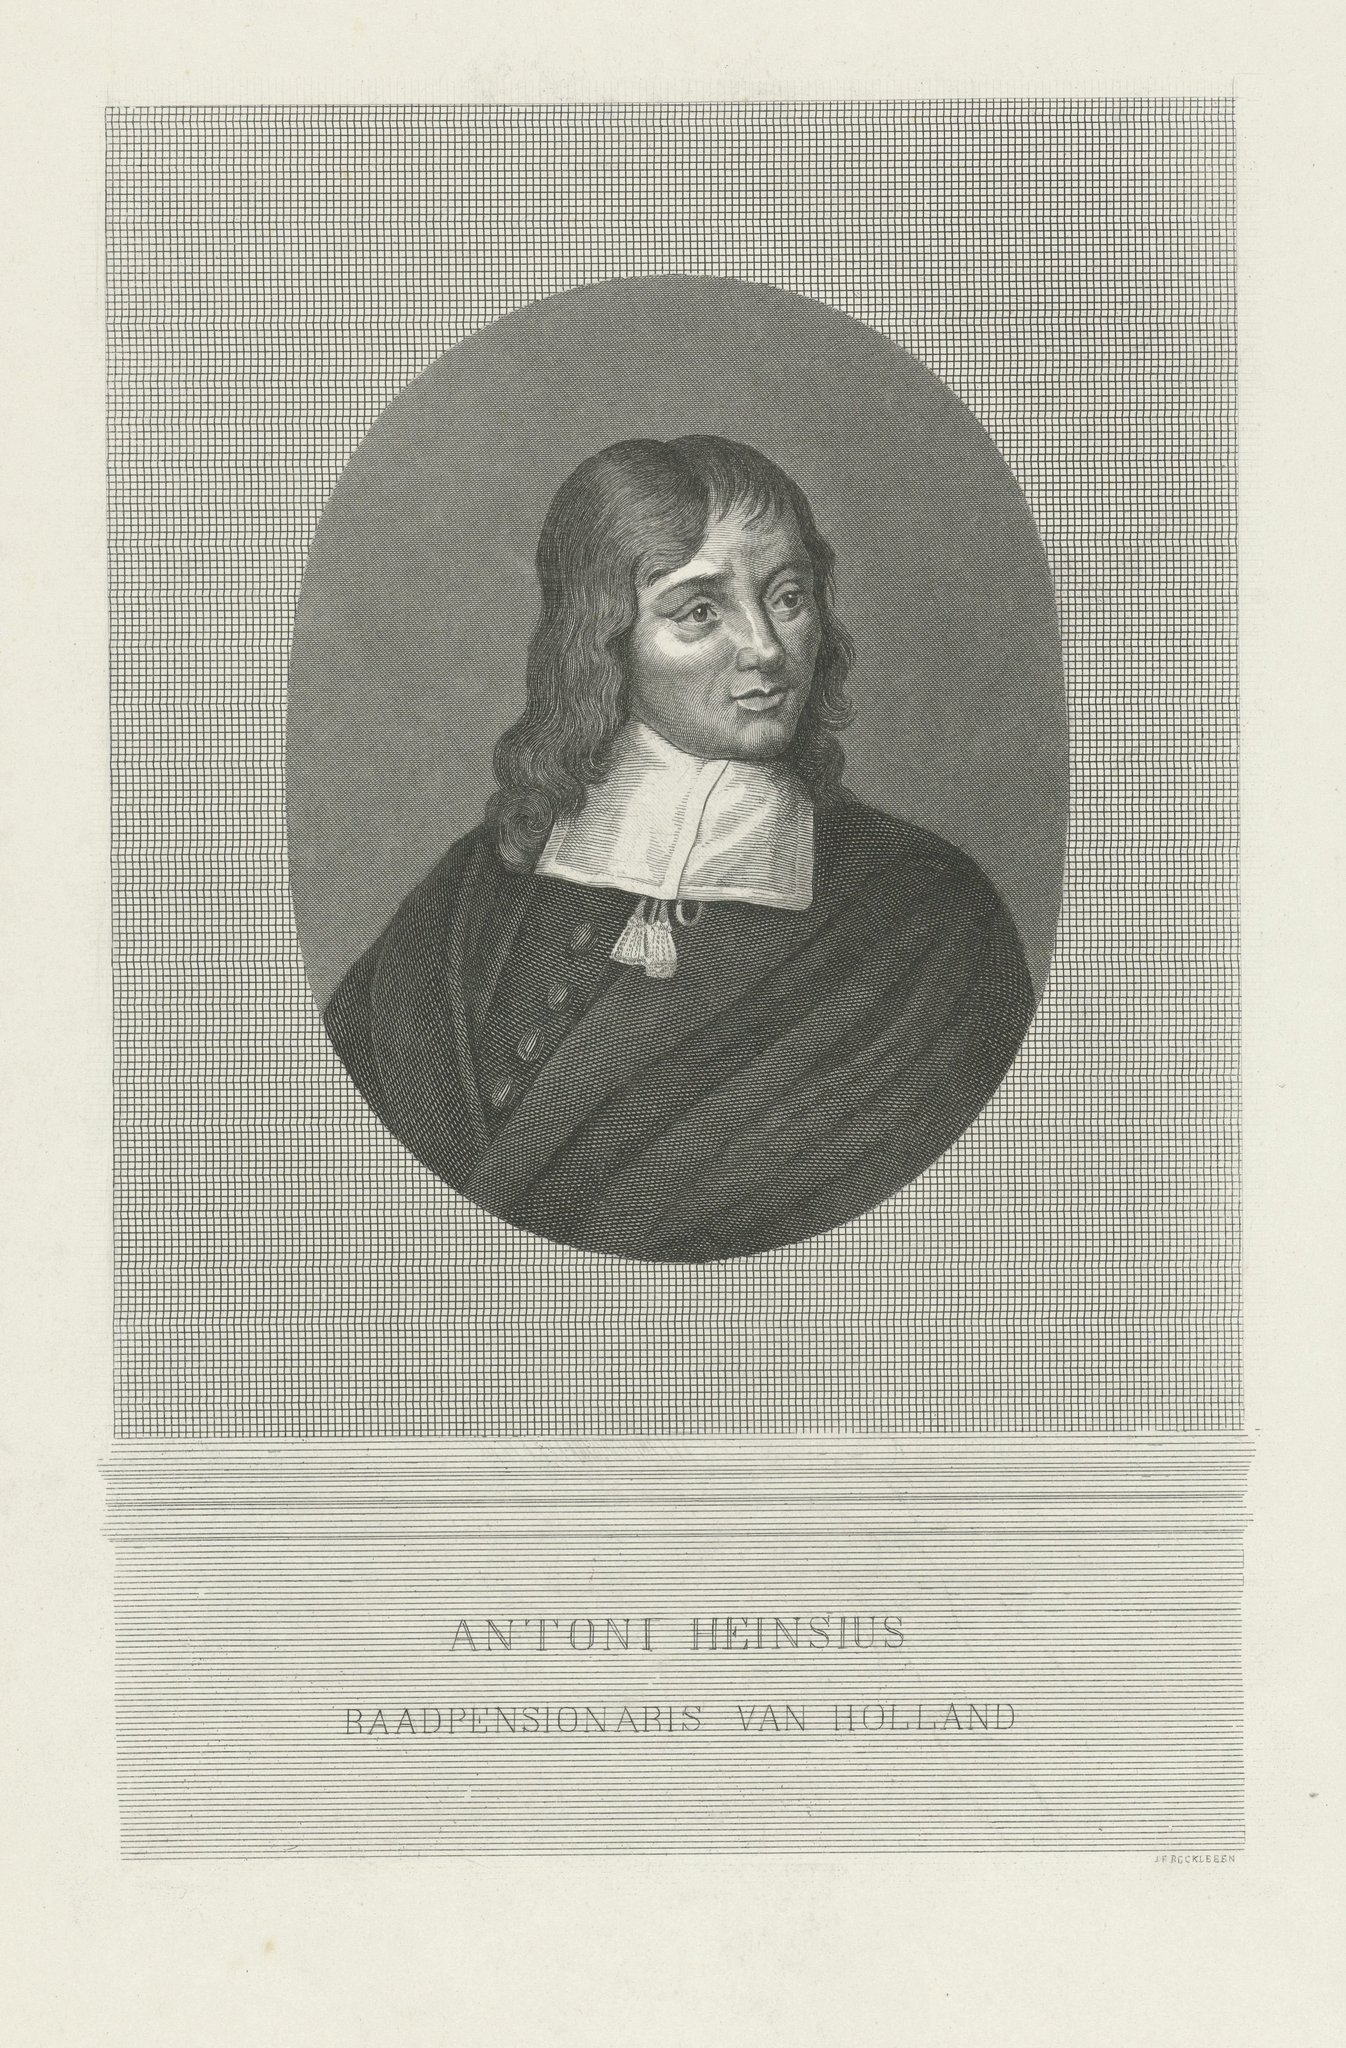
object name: print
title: Portret van Anthonie Heinsius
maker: jan frederik christiaan reckleben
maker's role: print maker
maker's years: 1819-1879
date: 1877-1879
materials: paper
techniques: engraving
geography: amsterdam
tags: the hague, anthonie heinsius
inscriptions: collector's mark: Lugt 2228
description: Illustratie in: Arend, Johannes Pieter. Algemeene geschiedenis des vaderlands van de vroegste tijden tot op heden. 5 delen, Amsterdam: Schleijer, J.F. 1840-1884, dl. 4.2, p. 783.